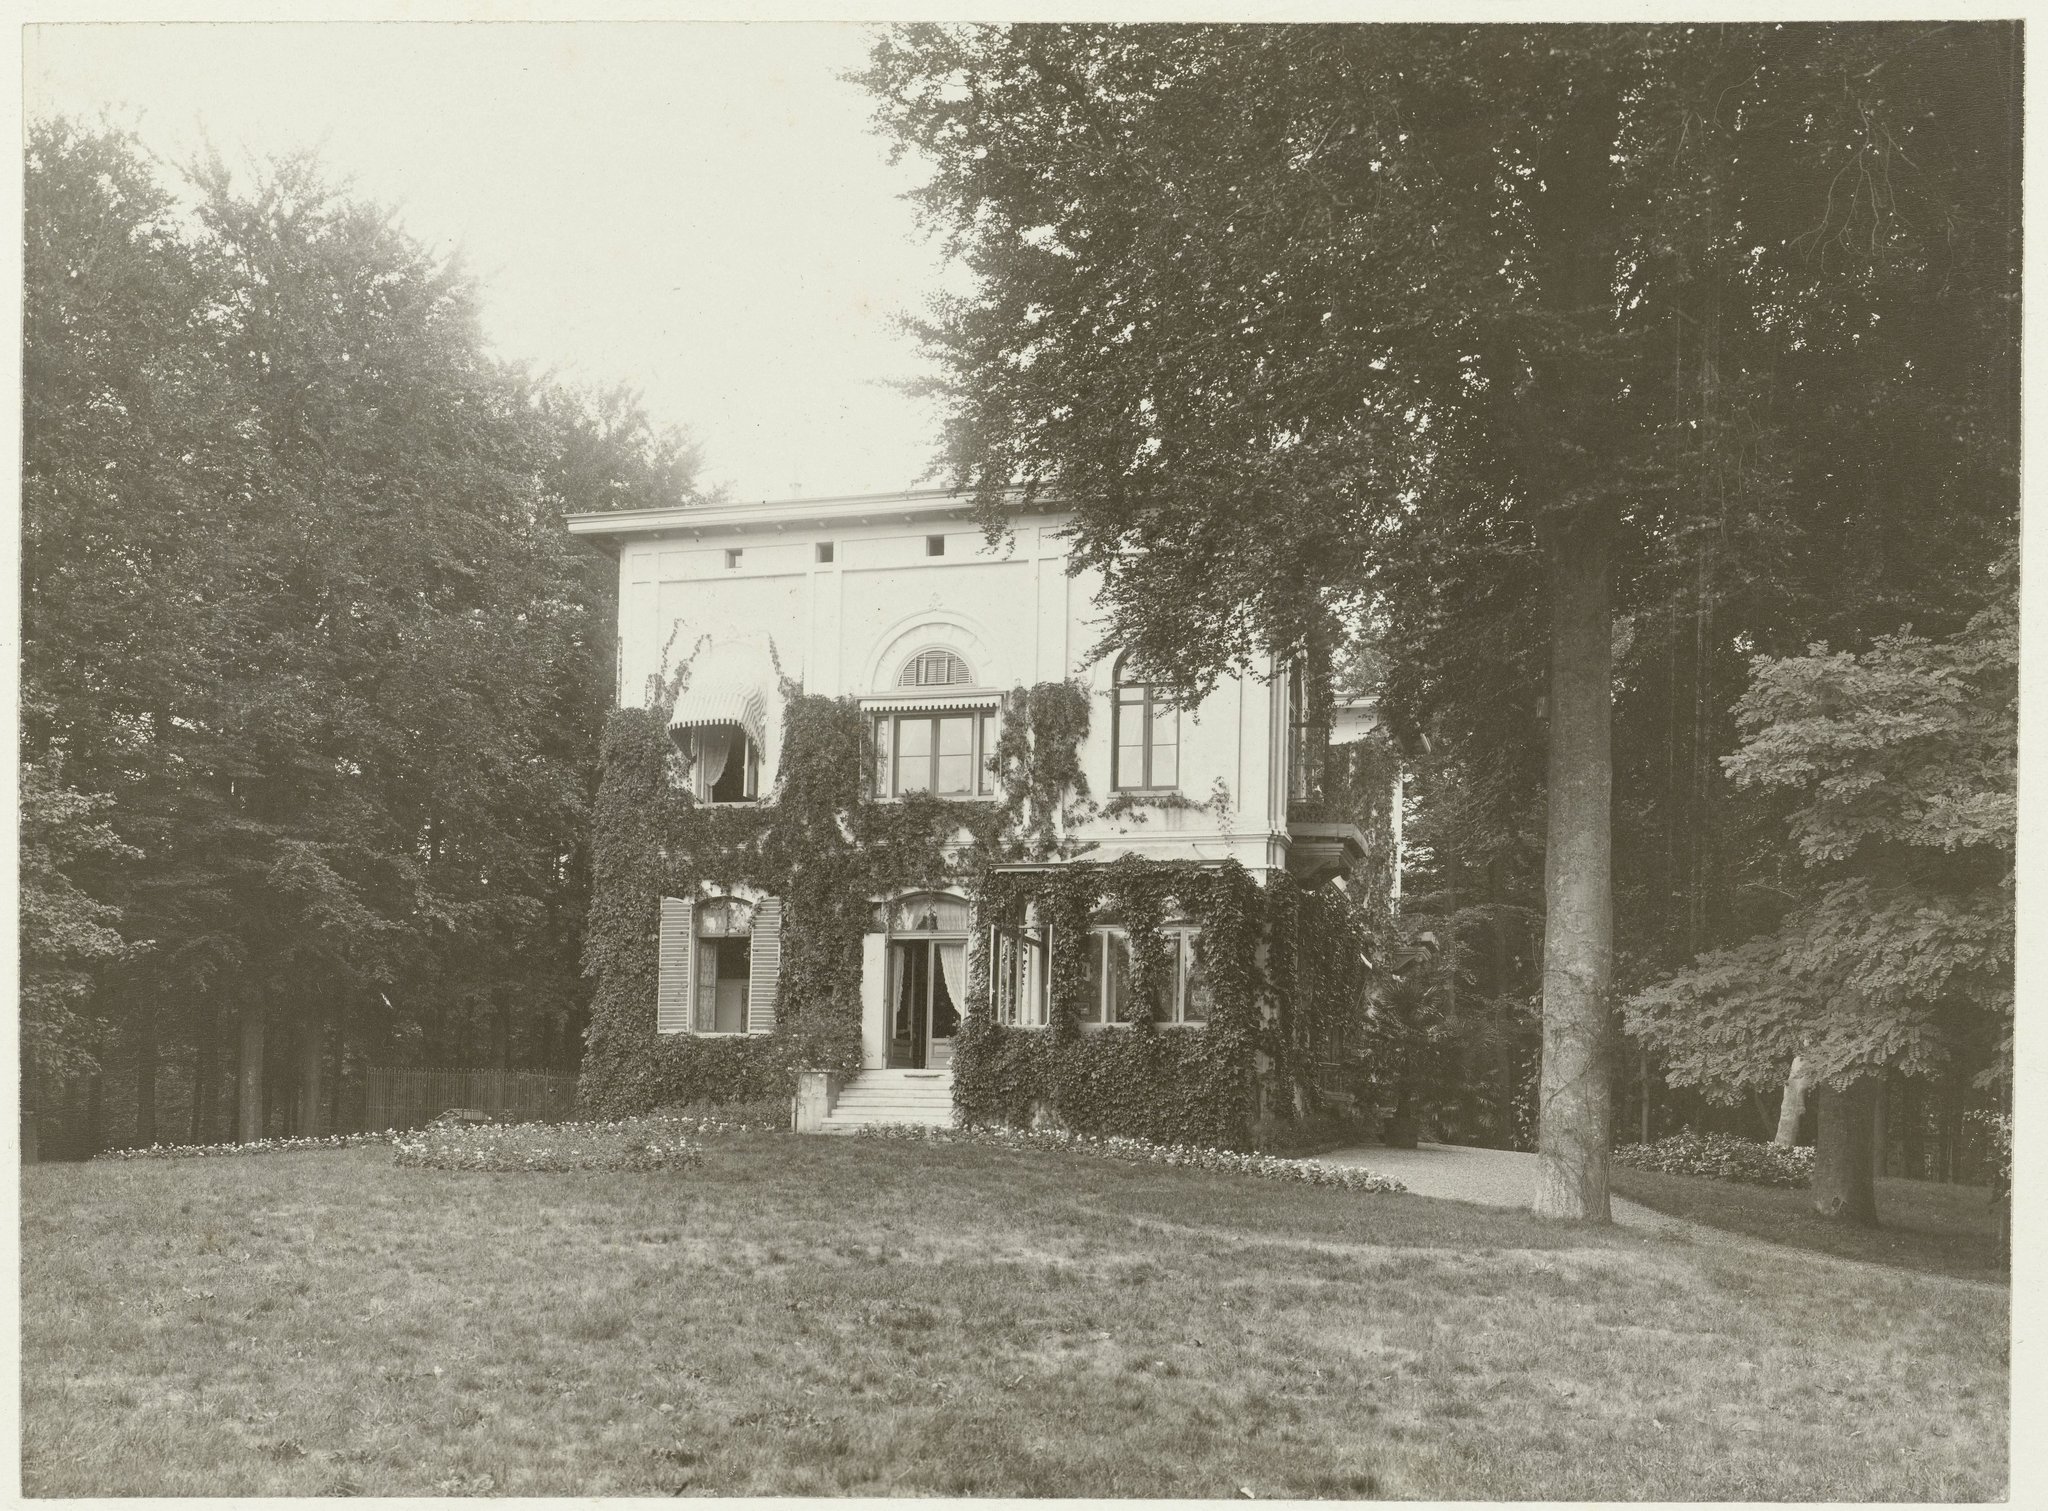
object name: photograph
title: Gezicht op landhuis De Wildbaan, Driebergen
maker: henry pauw van wieldrecht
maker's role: fotograaf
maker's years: 1863-1912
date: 1903-1907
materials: paper, photographic support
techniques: gelatin silver print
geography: netherlands